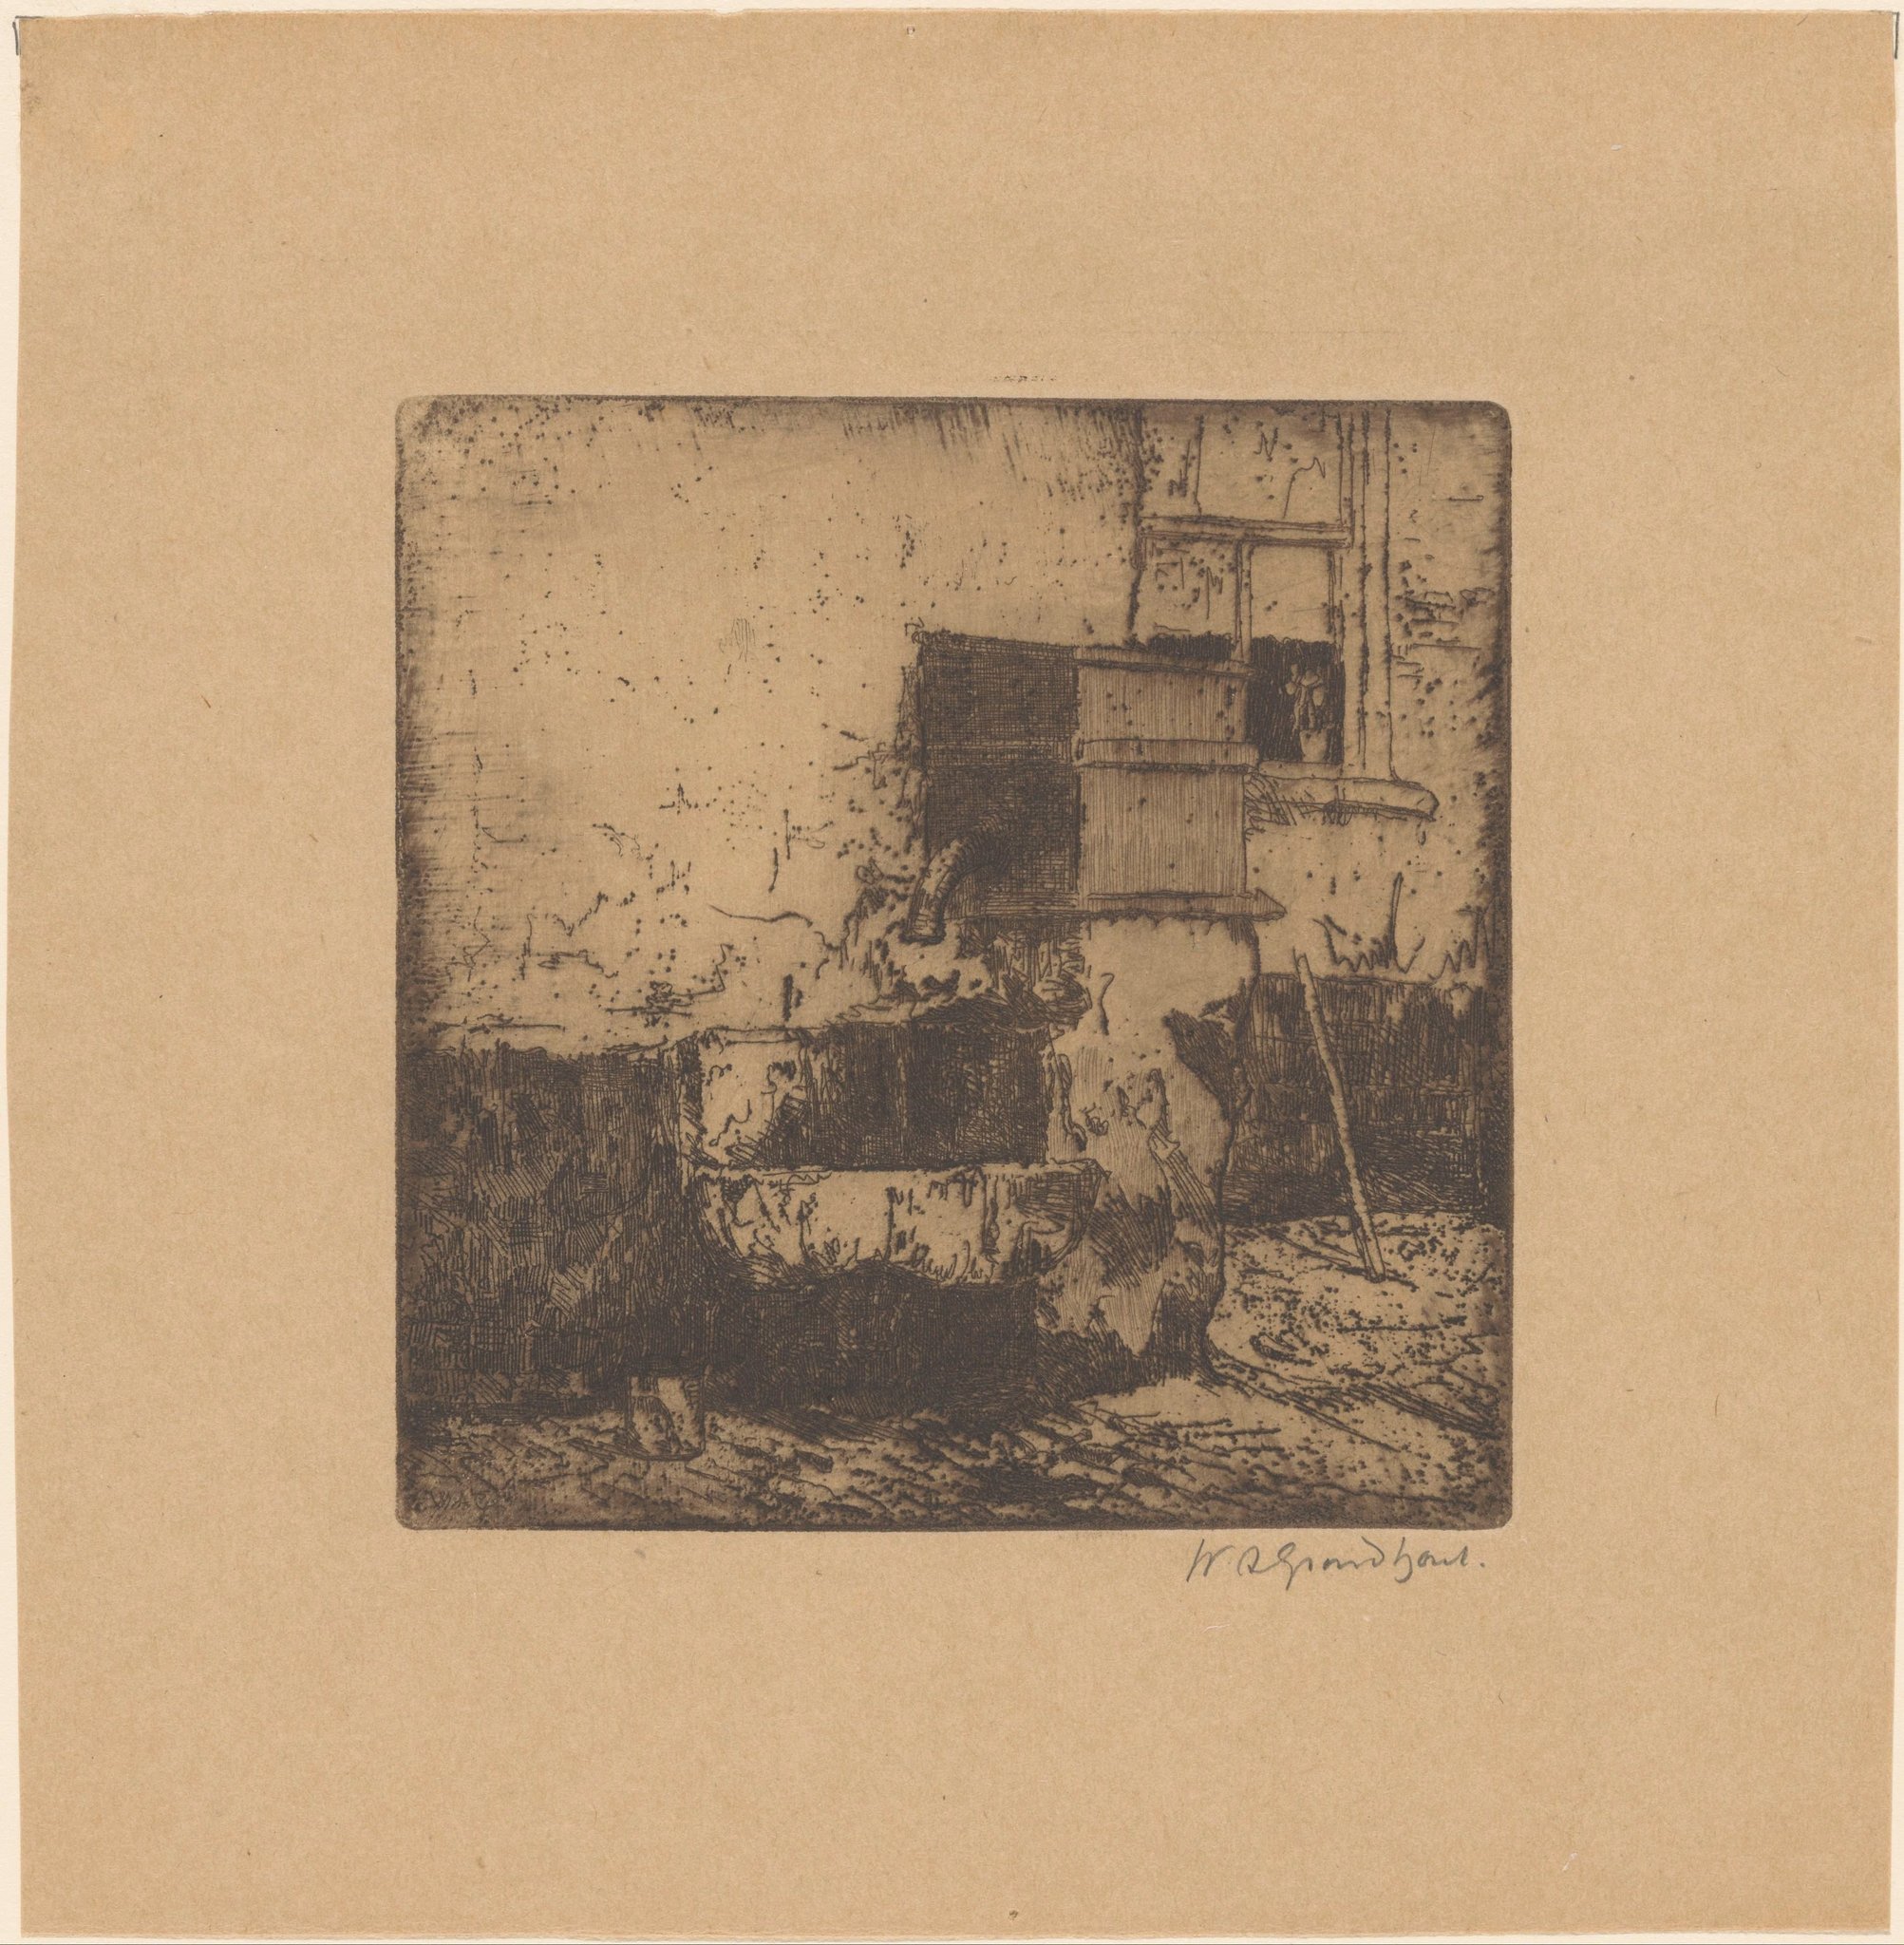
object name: print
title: Waterpomp bij een huis in Voorburg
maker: willem adrianus grondhout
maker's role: draughtsman, painter, print maker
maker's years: 1878-1934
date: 1888-1934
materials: paper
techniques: etching, intaglio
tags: well, voorburg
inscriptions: collector's mark: Lugt 2228